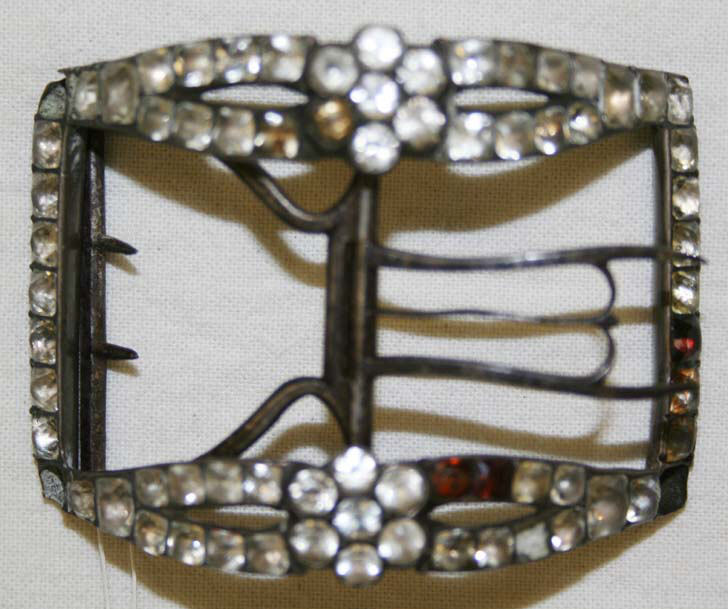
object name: shoe buckle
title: Shoe buckles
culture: british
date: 1767-1800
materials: metal, paste